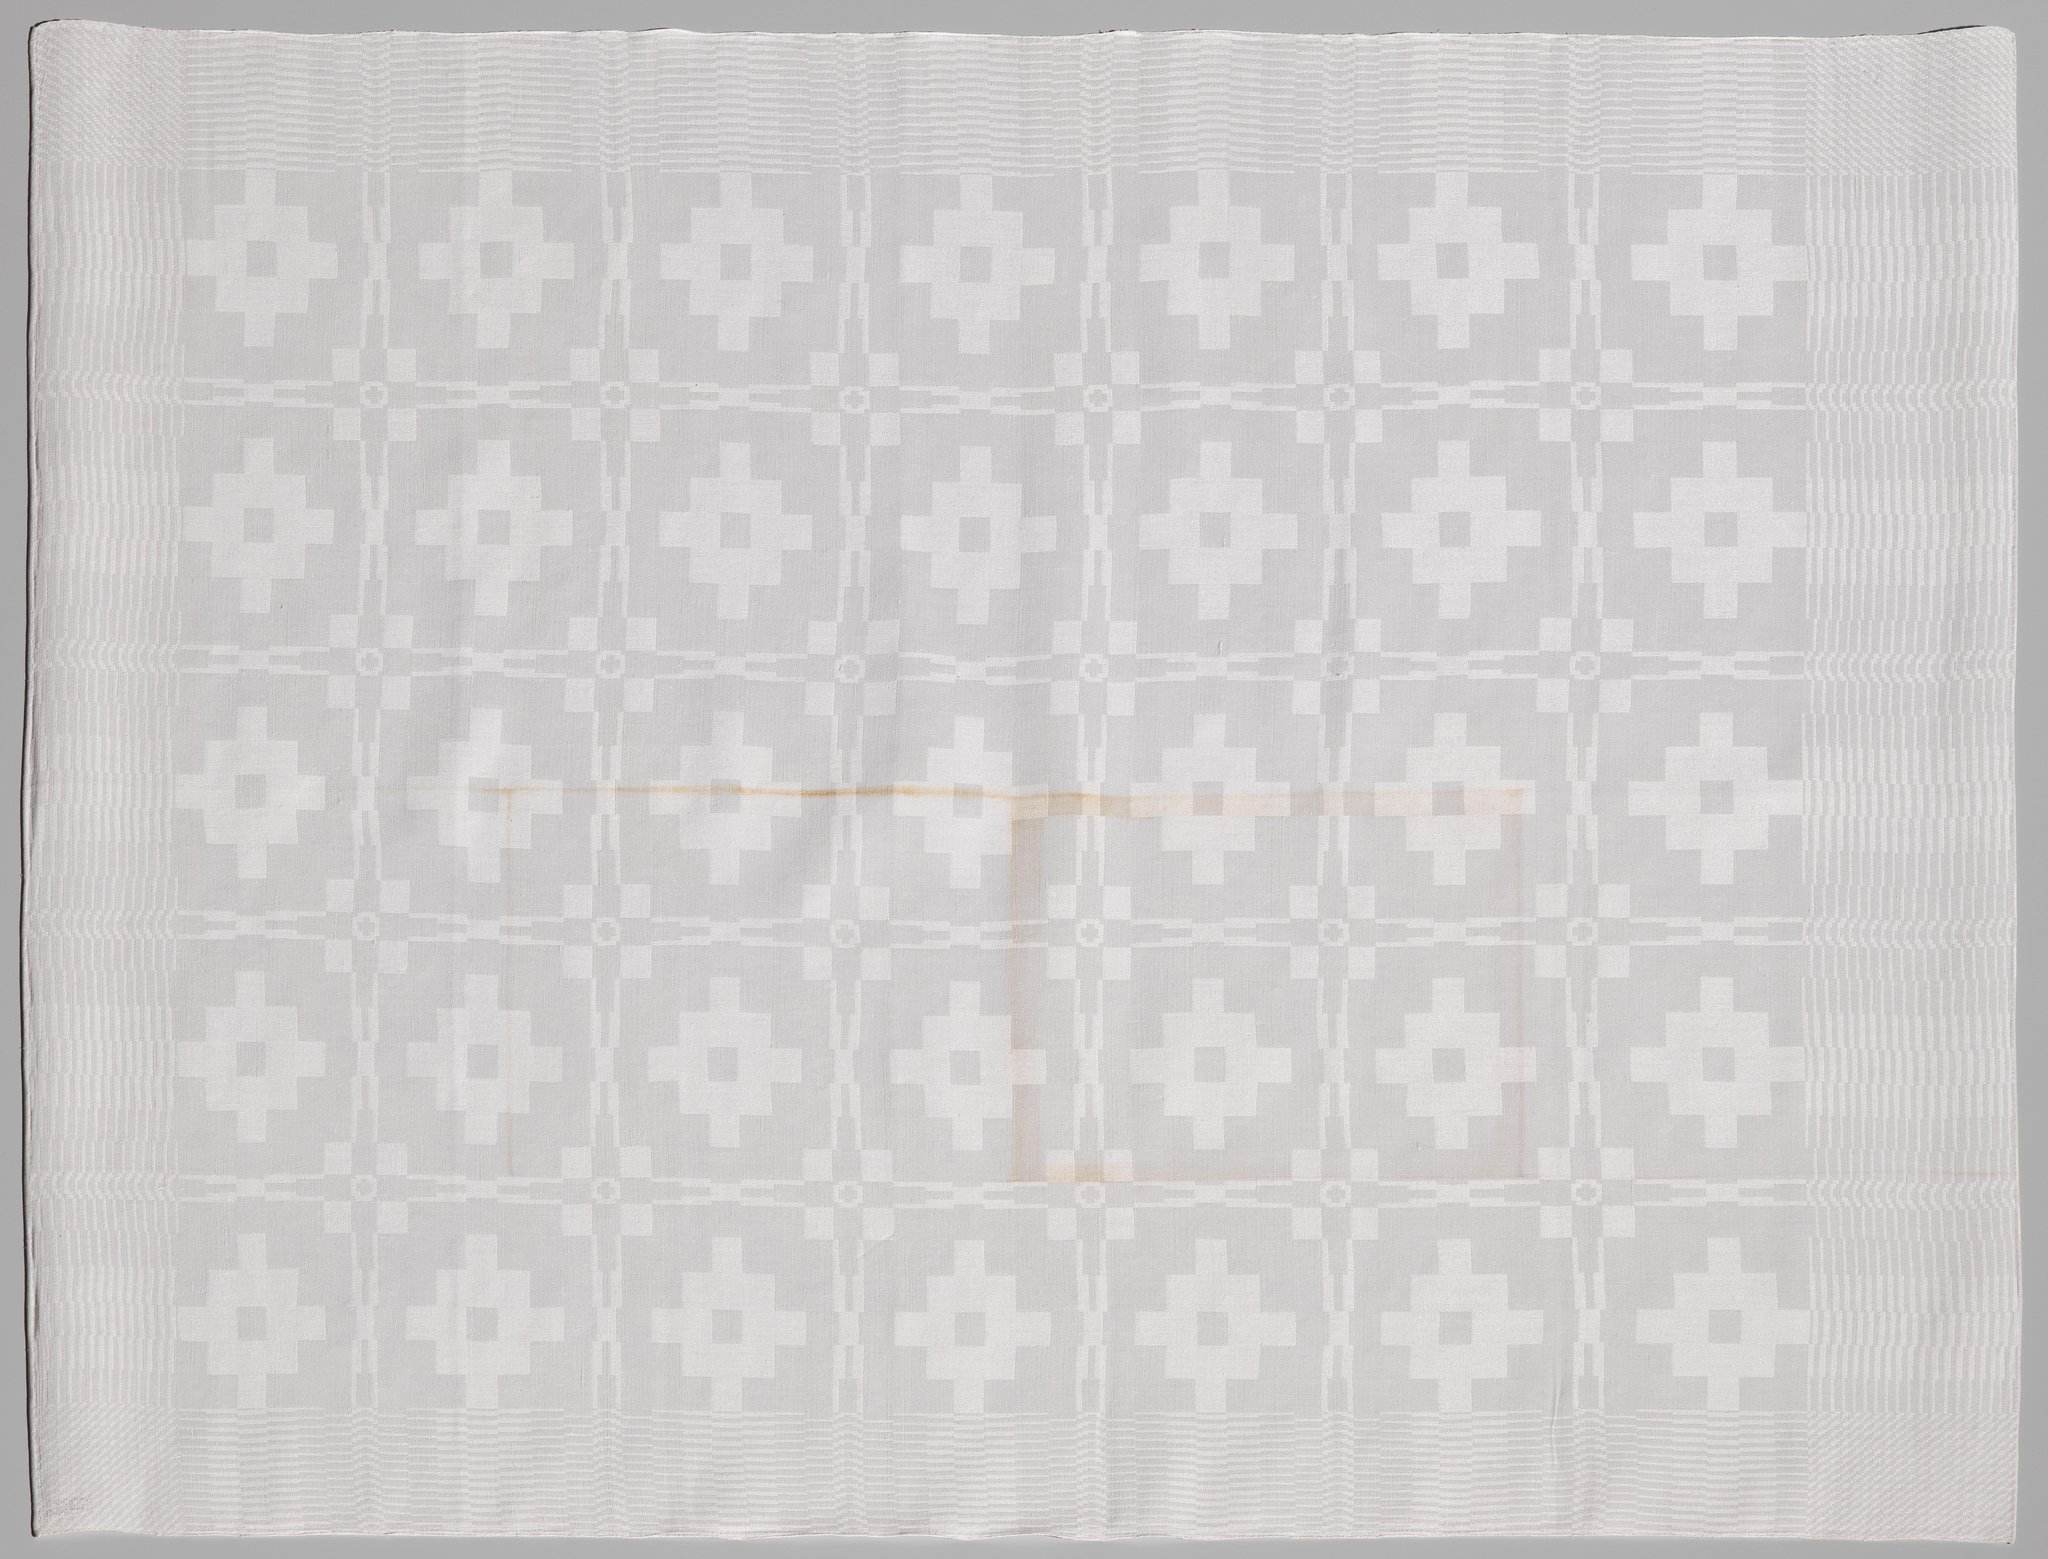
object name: napkin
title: Pellen met patroon 'uitgehouwen steen of hoekster'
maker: Anonymous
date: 1800-1899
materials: linen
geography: netherlands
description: Servet van wit linnen met pellenpatroon 'uitgehouwen steen of hoekster' en randen, merk H 13.